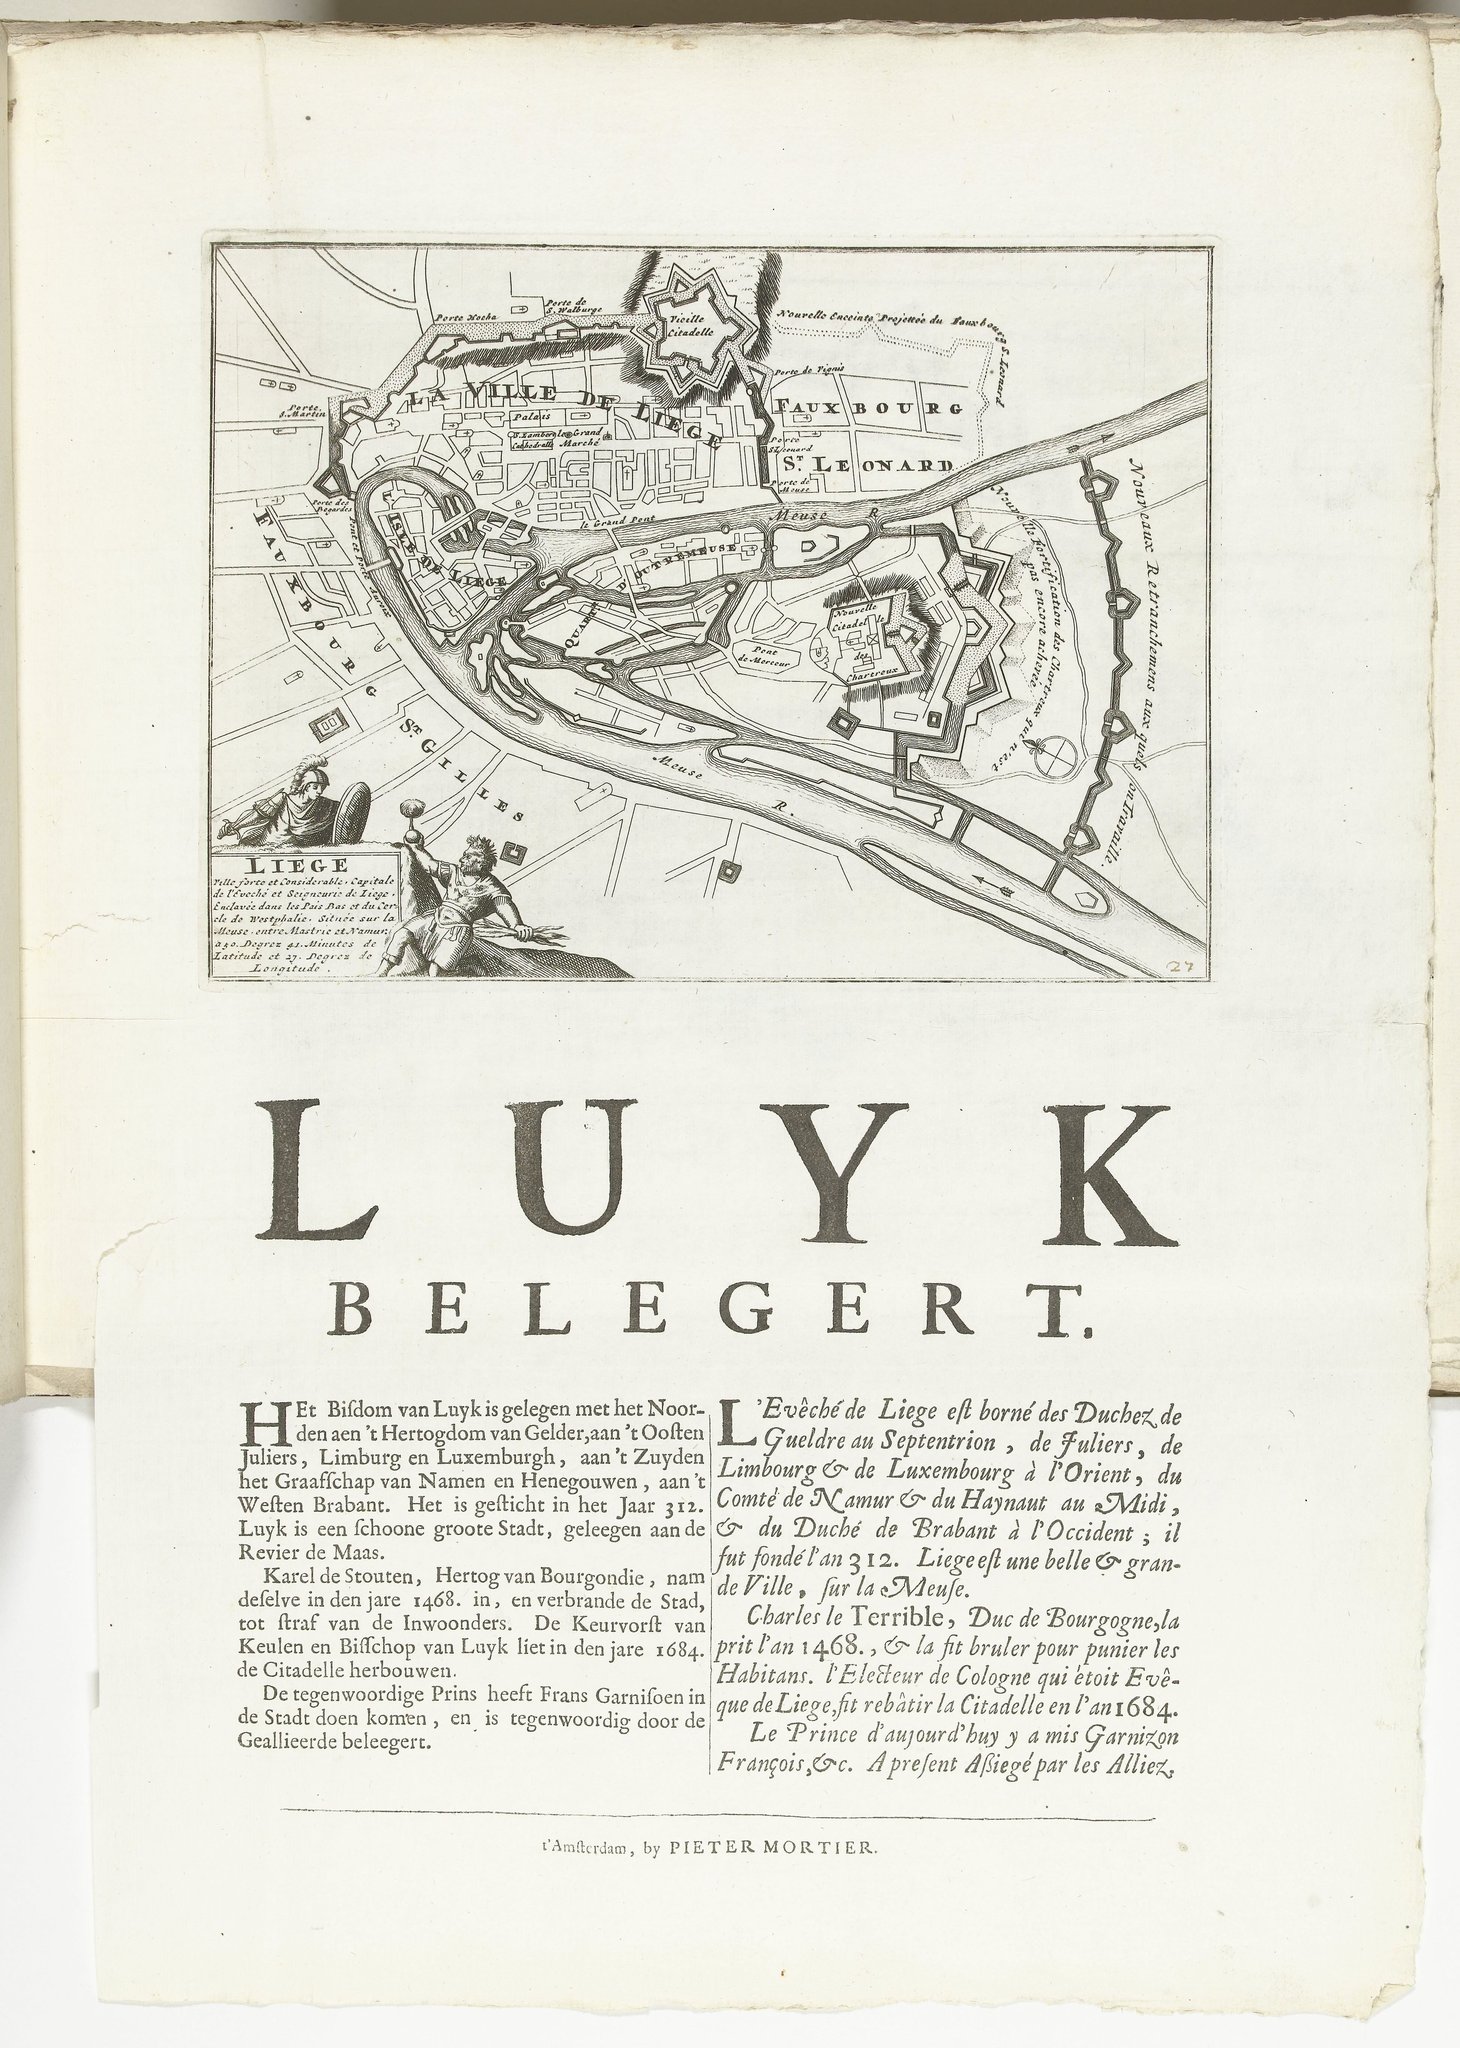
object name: map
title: Les Forces de l'Europe, Asie, Afrique et Amerique, ou description des principales villes avec leurs fortifications. Dessignées par les meilleurs ingenieurs, particulierement celles qui sont sous la domination de la France (...) et ornées de plusieurs superbes edifices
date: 1702-1703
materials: paper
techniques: etching, letterpress printing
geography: northern netherlands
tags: fortress, maps of cities, liège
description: Plattegrond van de verdedigingswerken om Luik, belegerd door de geallieerden, oktober 1702. Plaat nr. 27 in het prentwerk bestaande in totaal uit 276 genummerde platen van vermaarde sterke steden en vestingen in het kader van de Spaanse Successieoorlog. Voor het merendeel zijn deze platen gekopieerd naar de anonieme Franse platen: in Les forces de l'Europe en in: Le theatre de la guerre, dans les Pays-Bas, beide oorspronkelijk uitgegeven door Nicolas de Fer te Parijs (1693-1697) in het kader van de Negenjarige Oorlog. Titel en opschriften in de plaat in het Frans, tekst op het blad onder de plaat in het Frans en Nederlands.